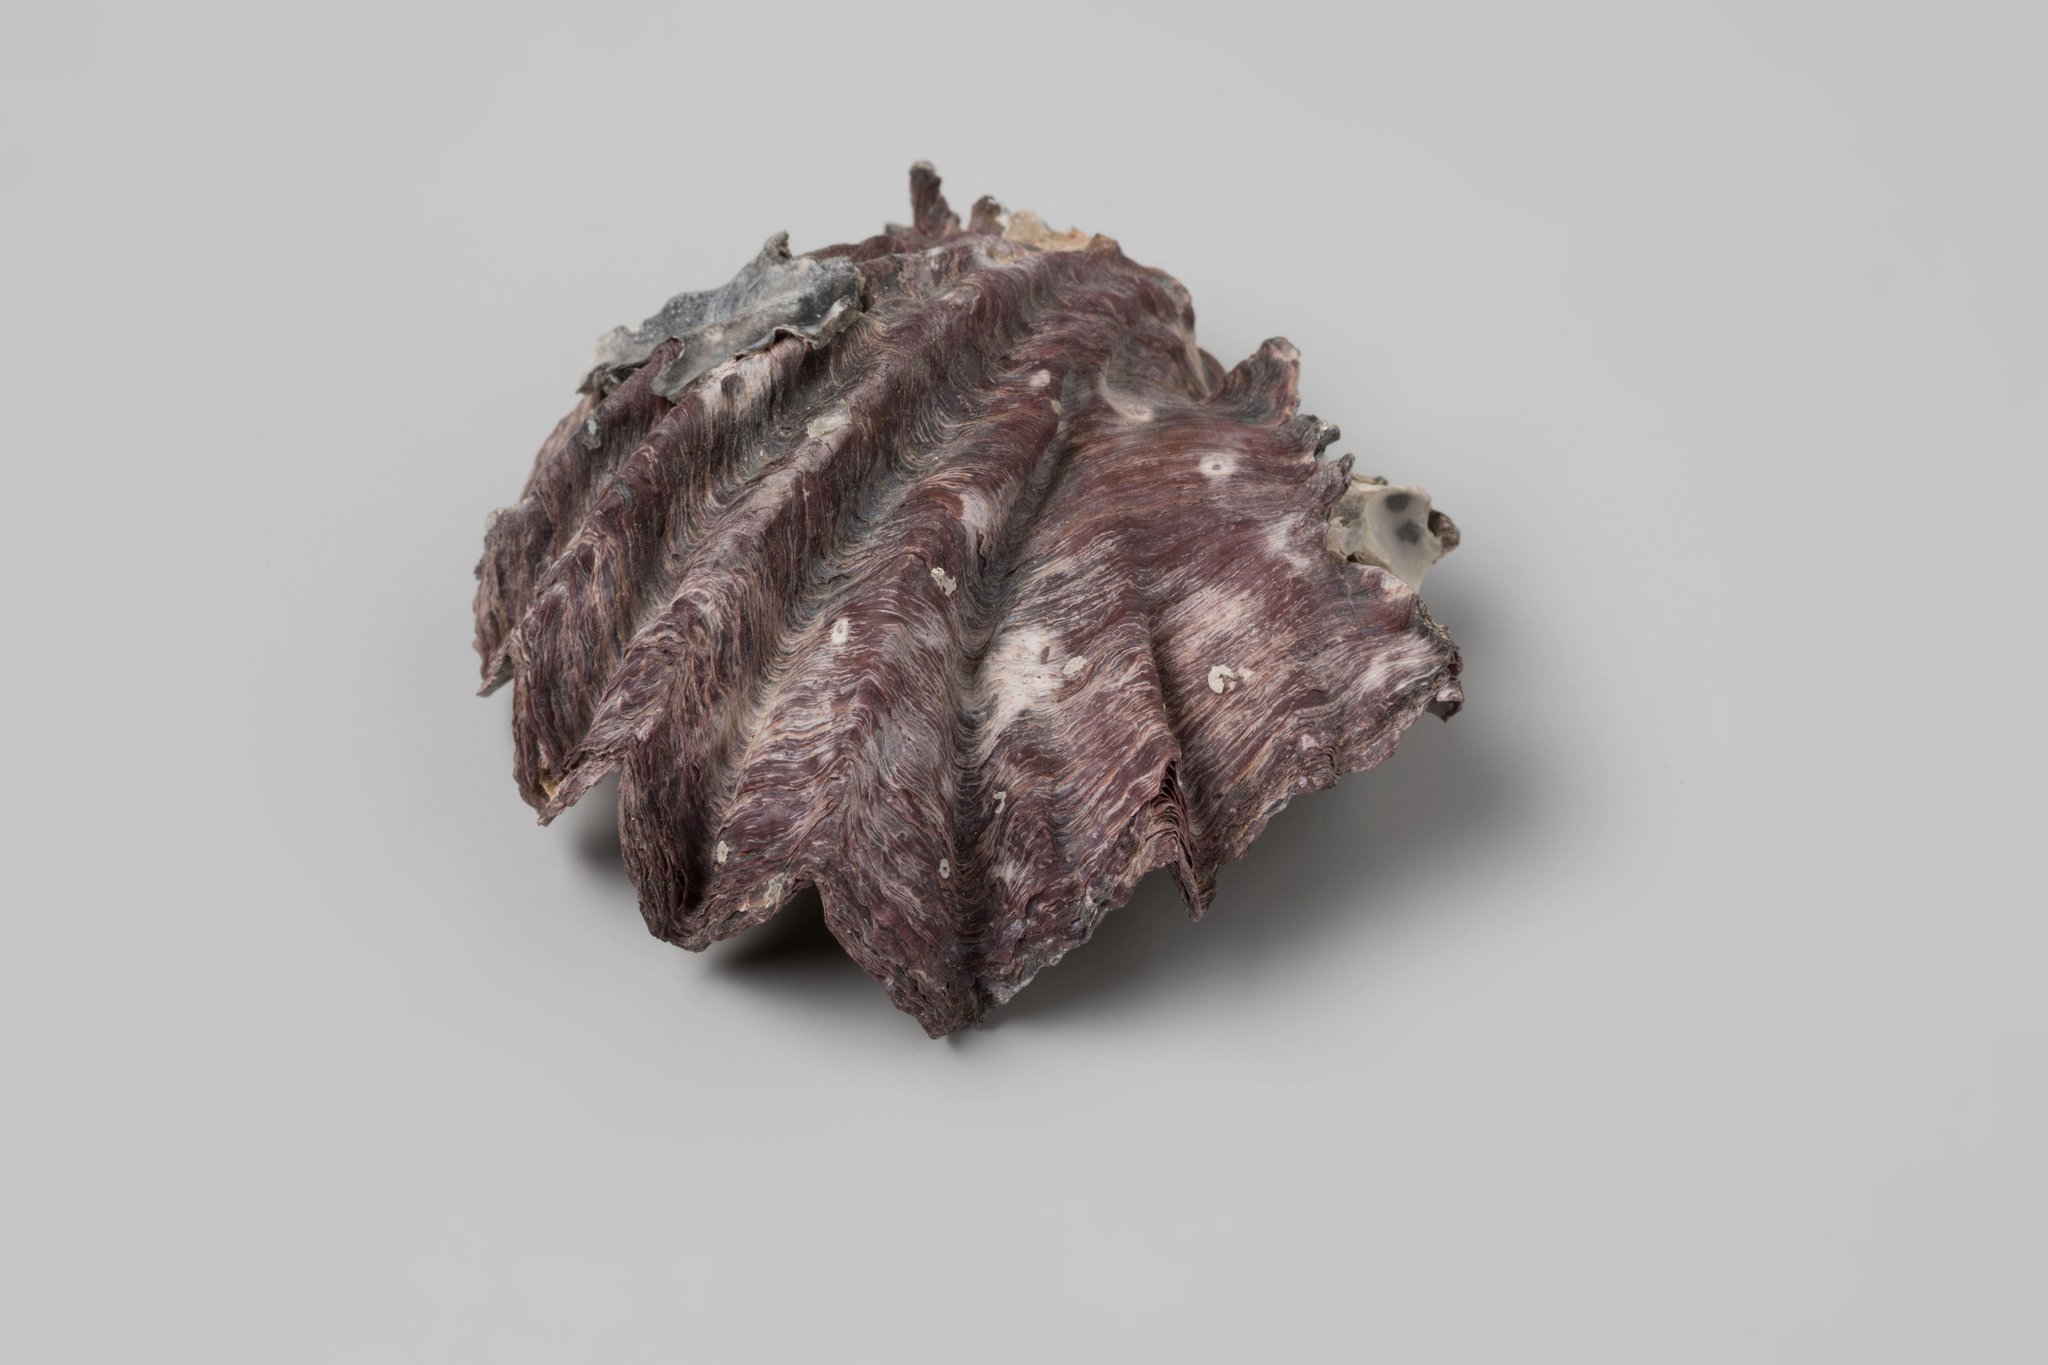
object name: crassostrea cristagalli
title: Crassostrea cristagalli shell from the wreck of the Dutch East India ship Witte Leeuw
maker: niet van toepassing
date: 1613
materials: shell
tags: verenigde oostindische compagnie, sint-helena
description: Schelp uit V.O.C.-schip de 'Witte Leeuw'.